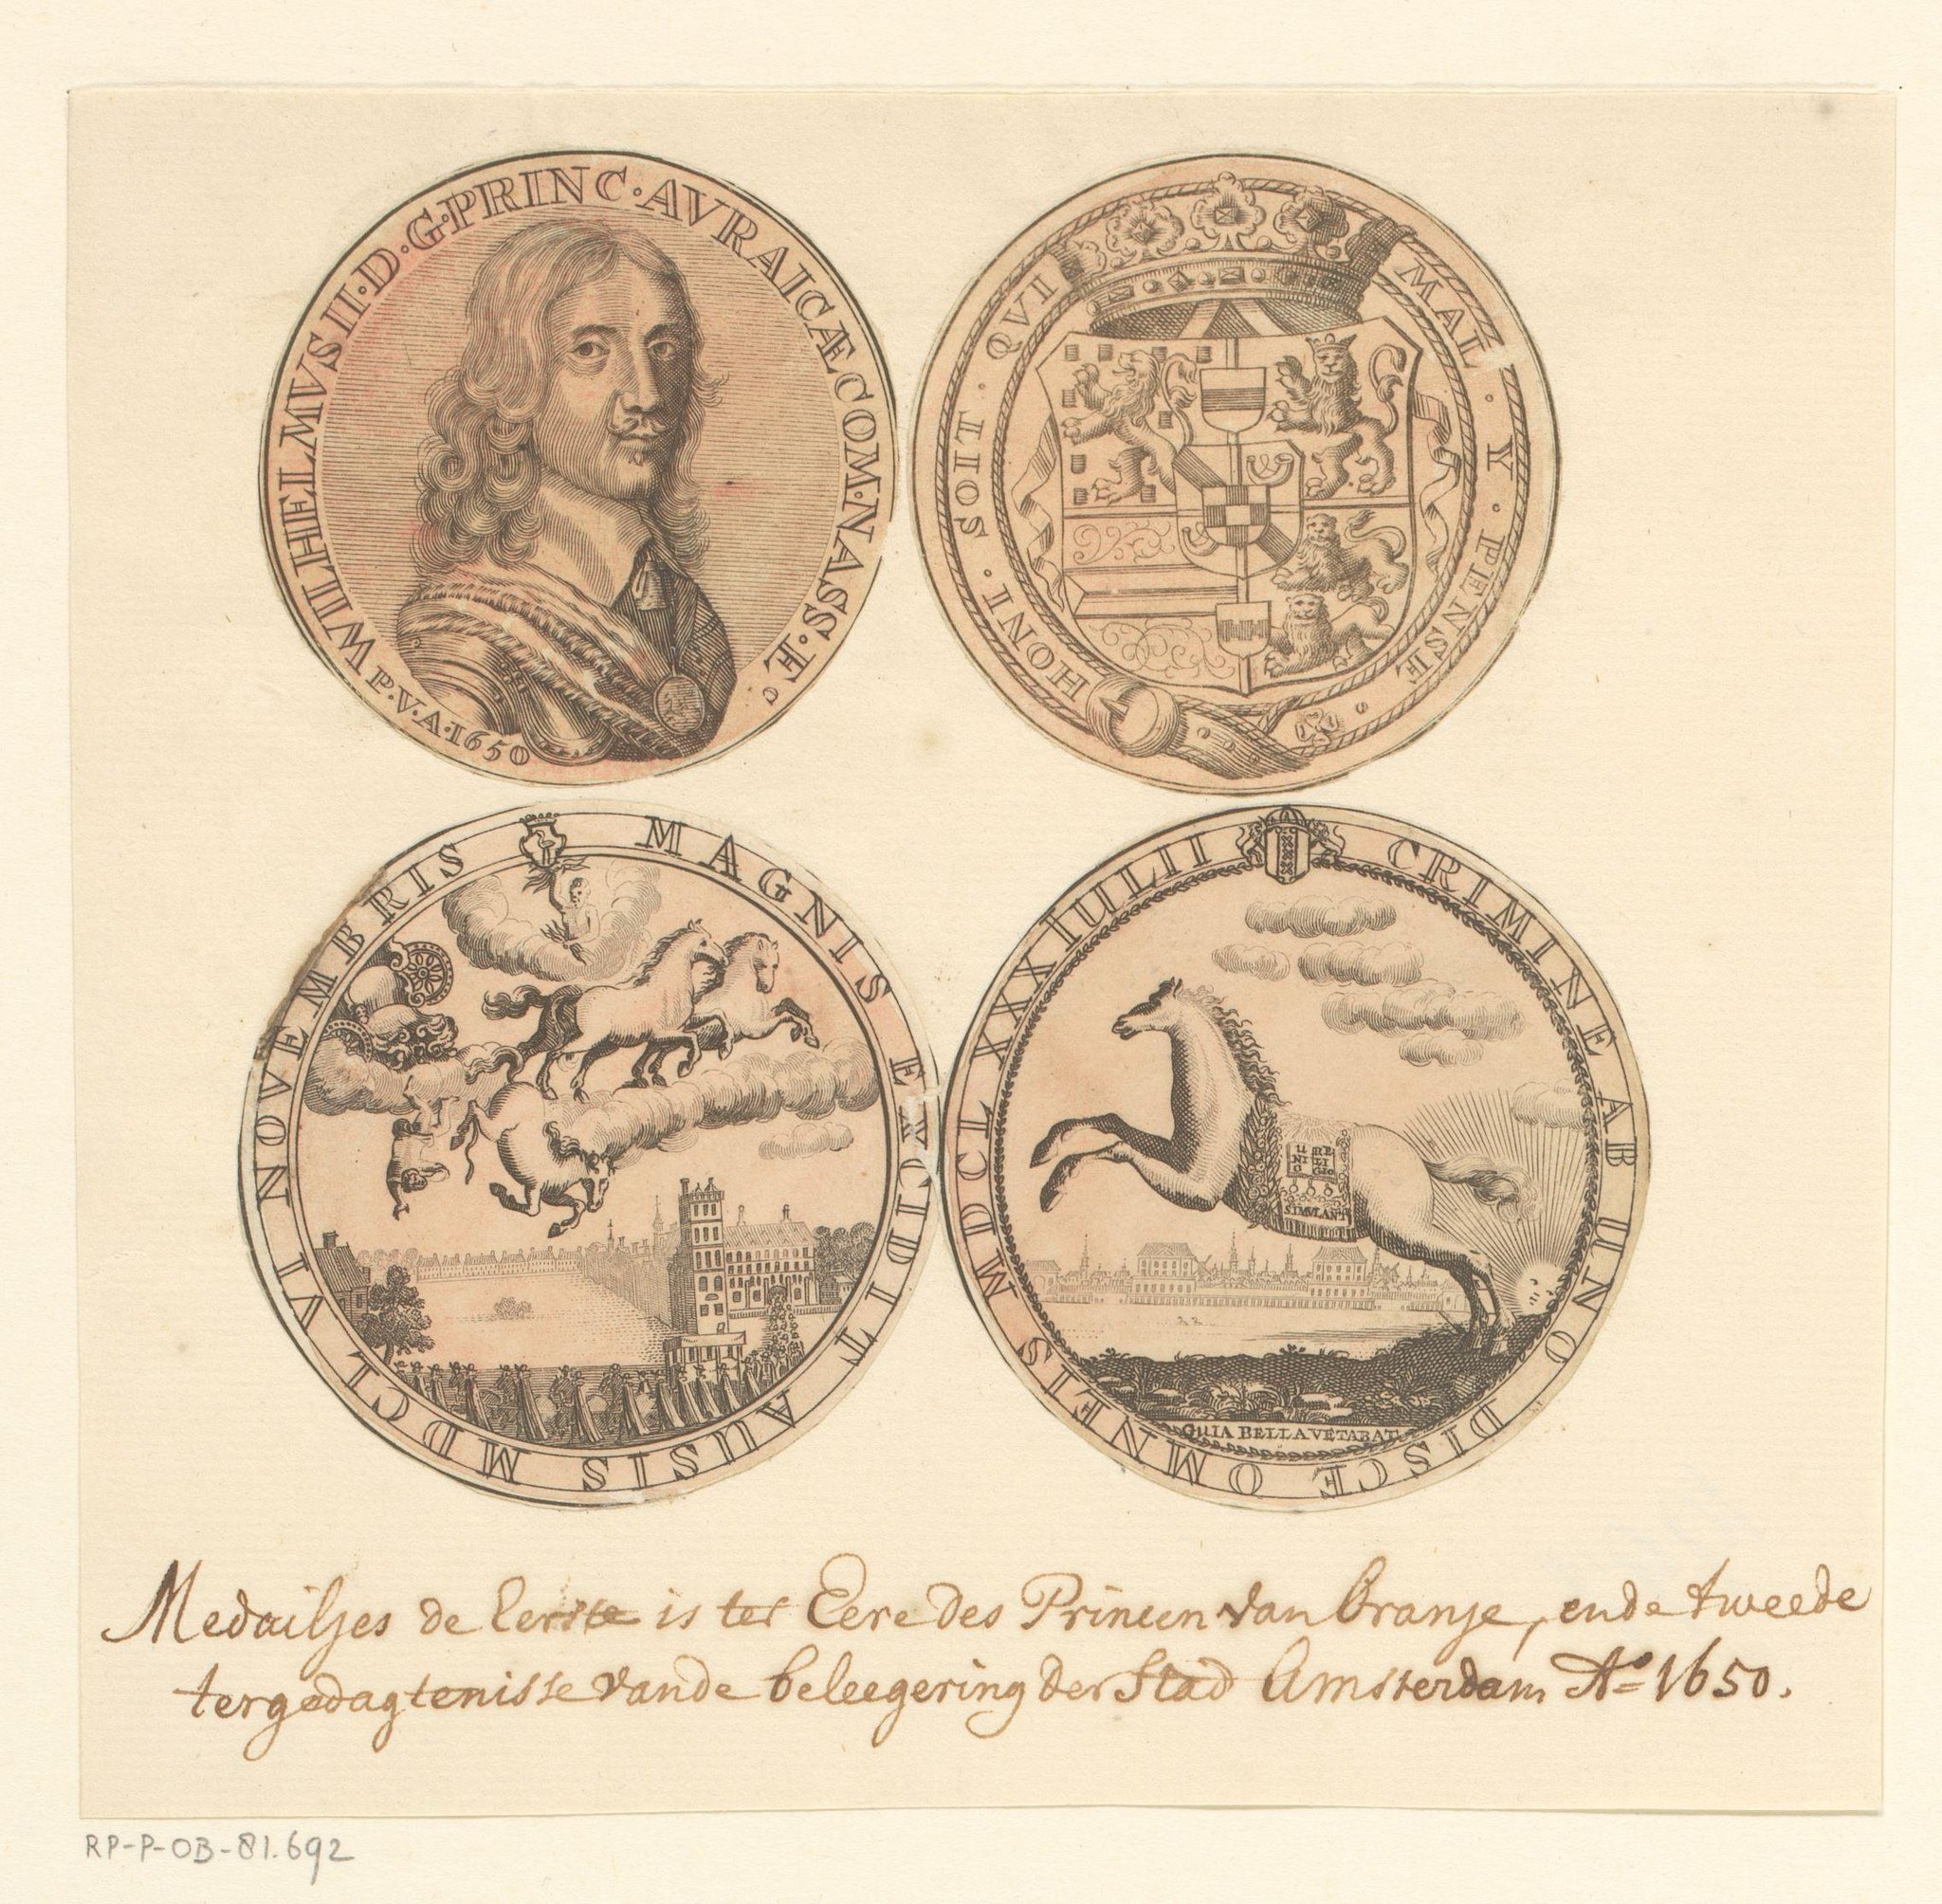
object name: historical object representation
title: Twee penningen van Willem II en het overlijden van Willem II, 1650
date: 1650-1749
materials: paper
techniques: etching, writing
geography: northern netherlands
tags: william ii (prince of orange), medal (considered as a piece of sculpture, regardless of its specific function), amsterdam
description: Een penning ter ere van prins Willem II. Voorzijde: portret van Willem II. Keerzijde: zijn wapen. Een penning over de mislukte aanslag op Amsterdam door prins Willem II op 30 juli 1650 en de begrafenisstoet van de prins in Den Haag, 8 maart 1651. Voorzijde: rennend paard, met krijgslieden onder dekkleed; op achtergrond gezicht op de blokhuizen aan de Amstel. Keerzijde: de val van Phaëthon, daaronder de lijkstoet bij het Hof in Den Haag. Vier uitgeknipte en opgeplakte rondjes op een blad papier met annotatie.